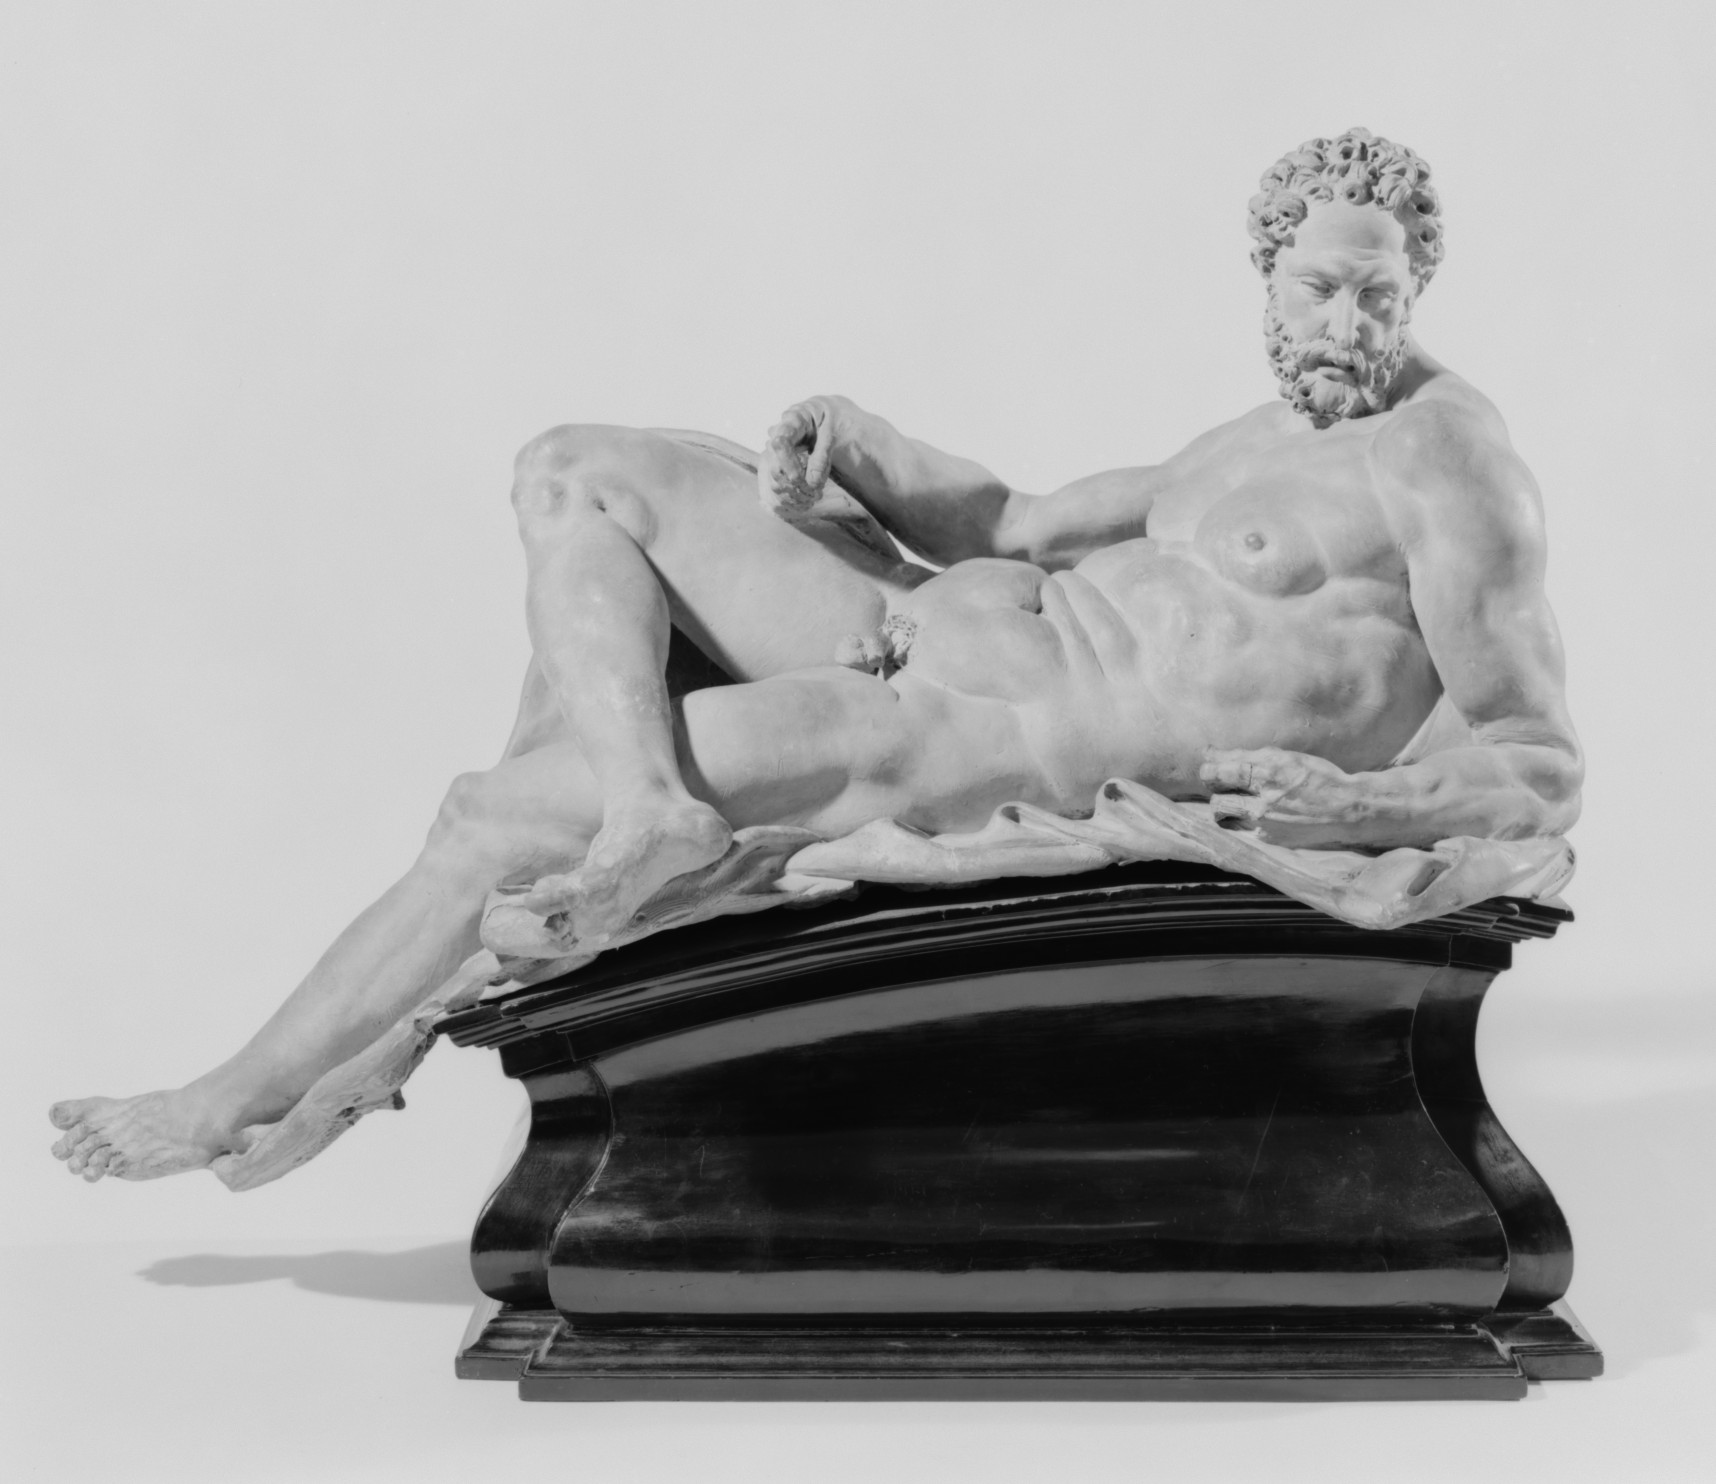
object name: statuette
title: The Dusk (one of a pair)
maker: michelangelo buonarroti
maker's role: artist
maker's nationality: italian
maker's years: 1475-1564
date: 1600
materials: terracotta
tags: male nudes